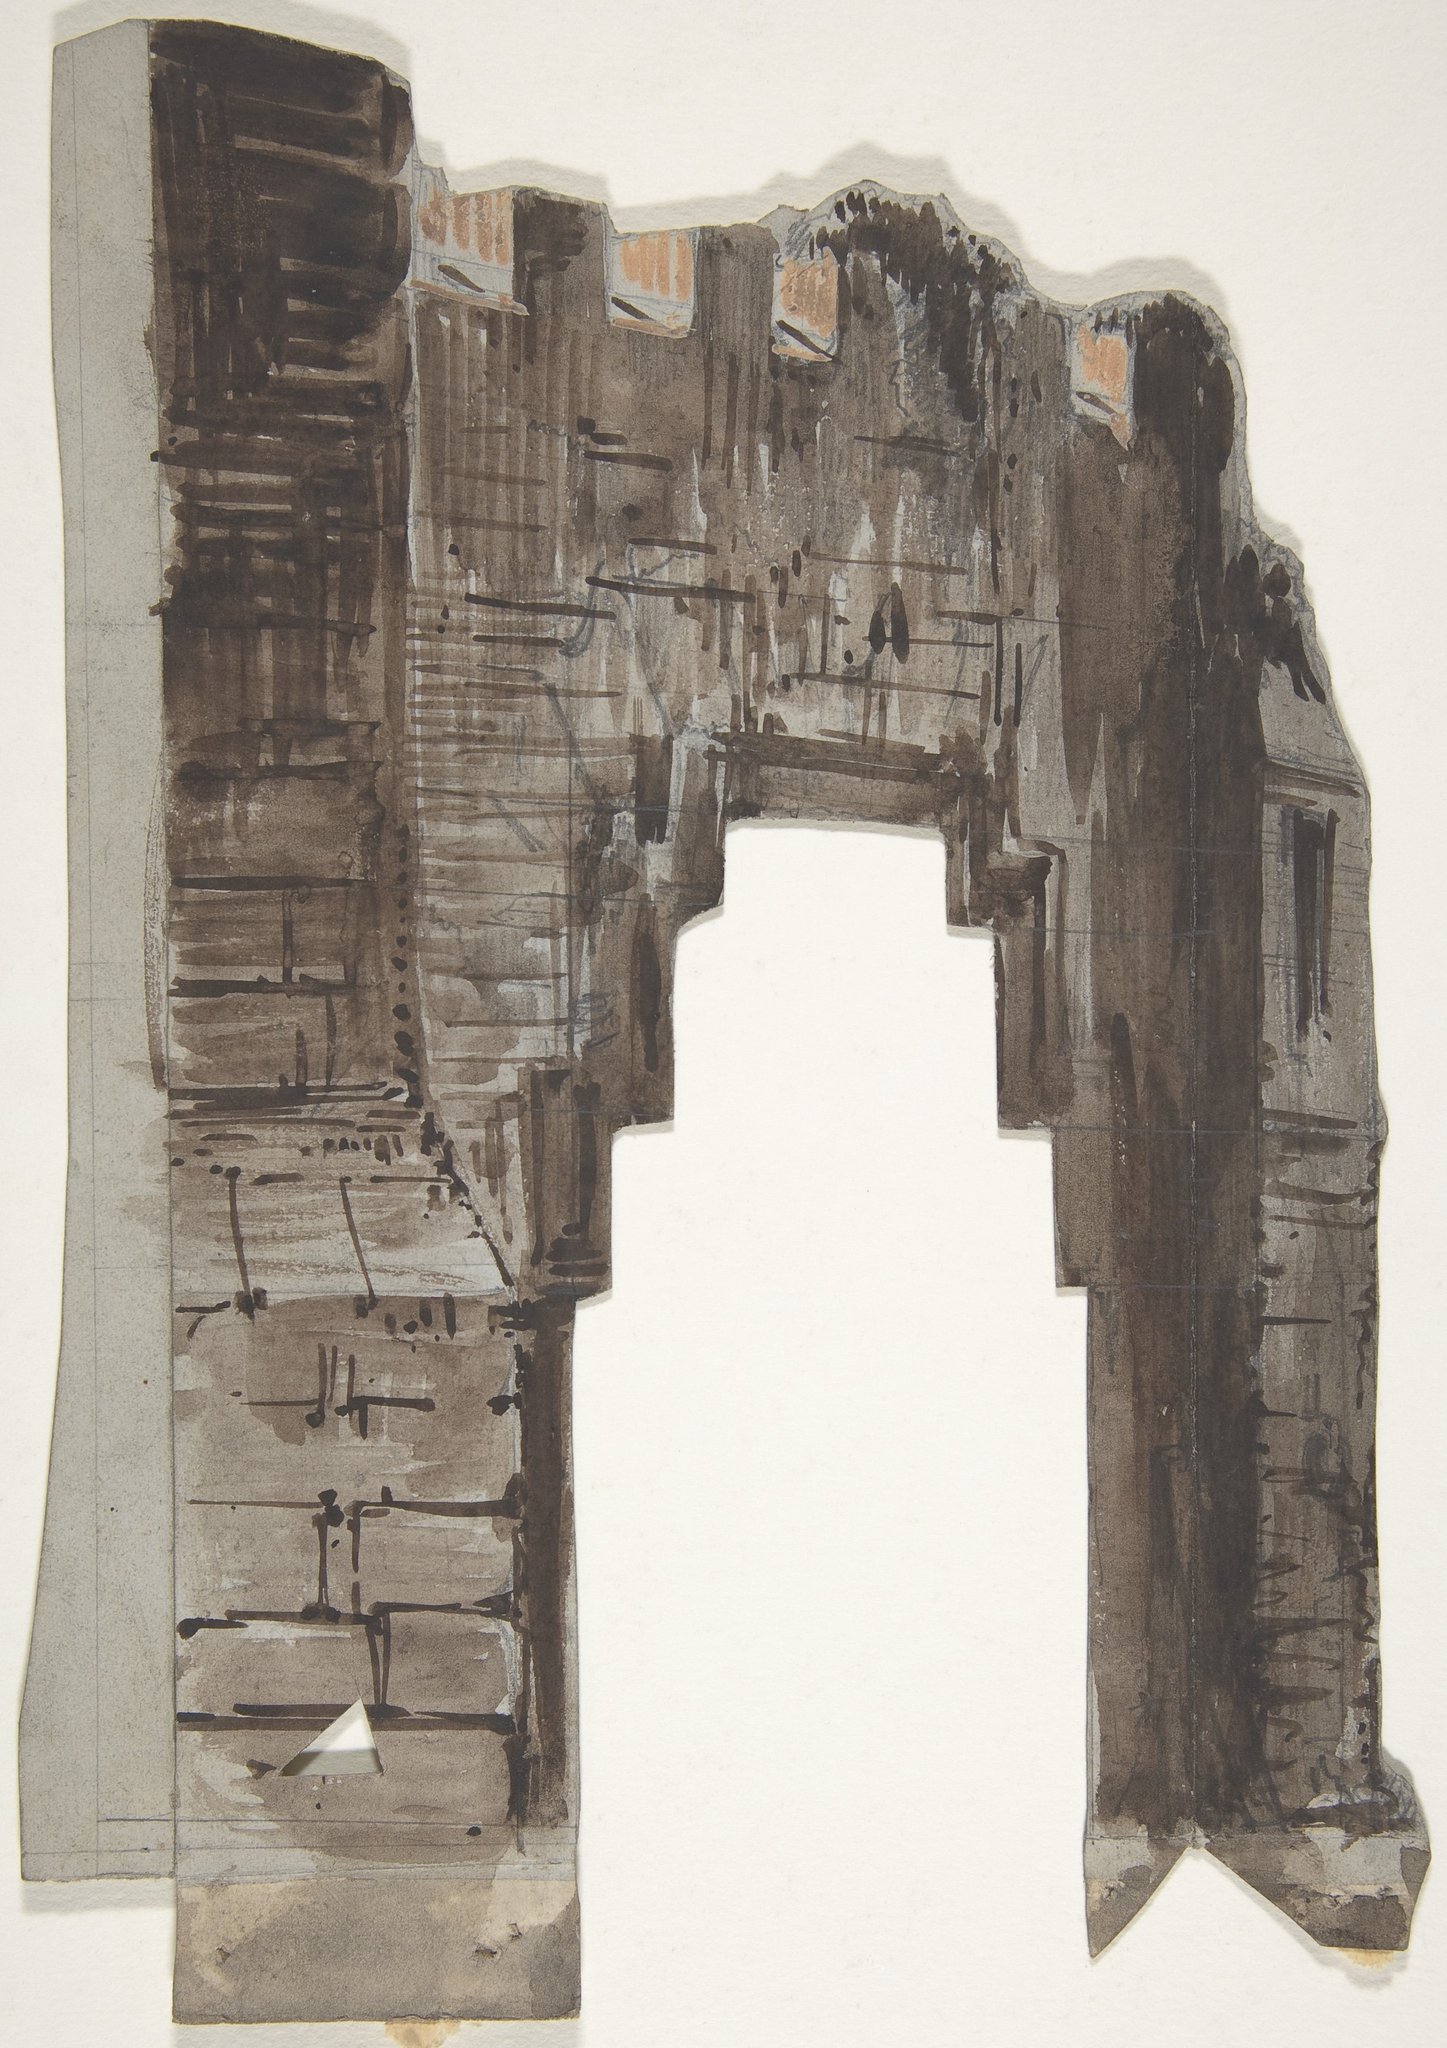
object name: drawing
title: Design for a Stage Set at the Opéra, Paris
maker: eugène cicéri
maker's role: artist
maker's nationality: french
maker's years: 1813-1890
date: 1828-1890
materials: graphite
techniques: brush, wash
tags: stage design